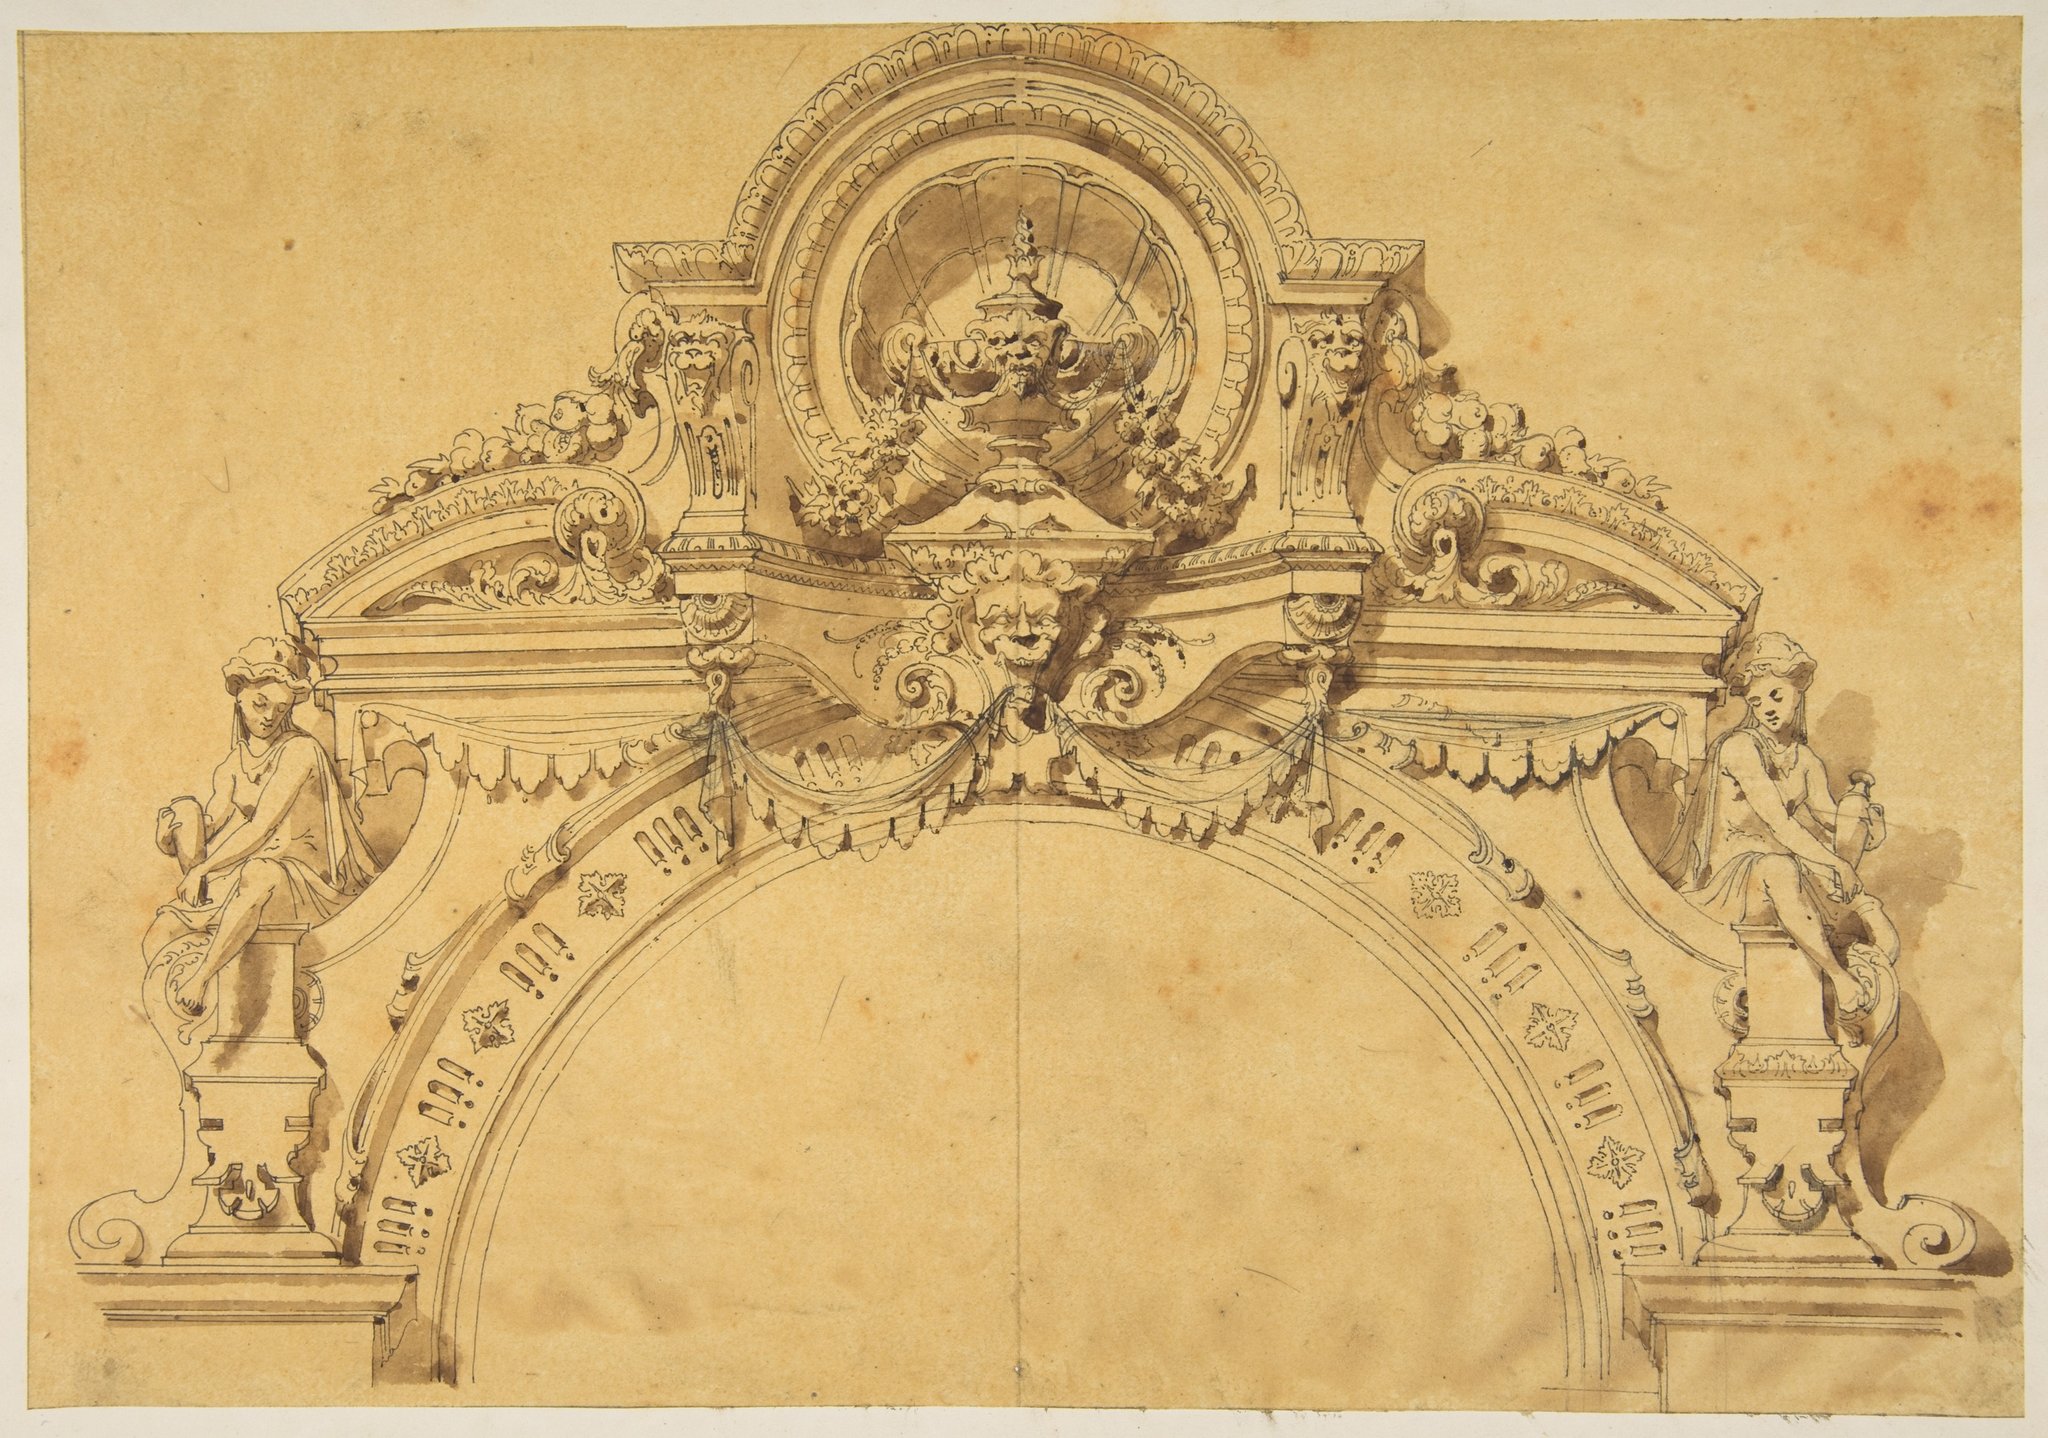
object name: drawing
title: Design for an elaborate arch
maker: anonymous, french, 19th century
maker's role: artist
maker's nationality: french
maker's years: 1800-1900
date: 1801-1900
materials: ink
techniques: pen, wash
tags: architecture,arches